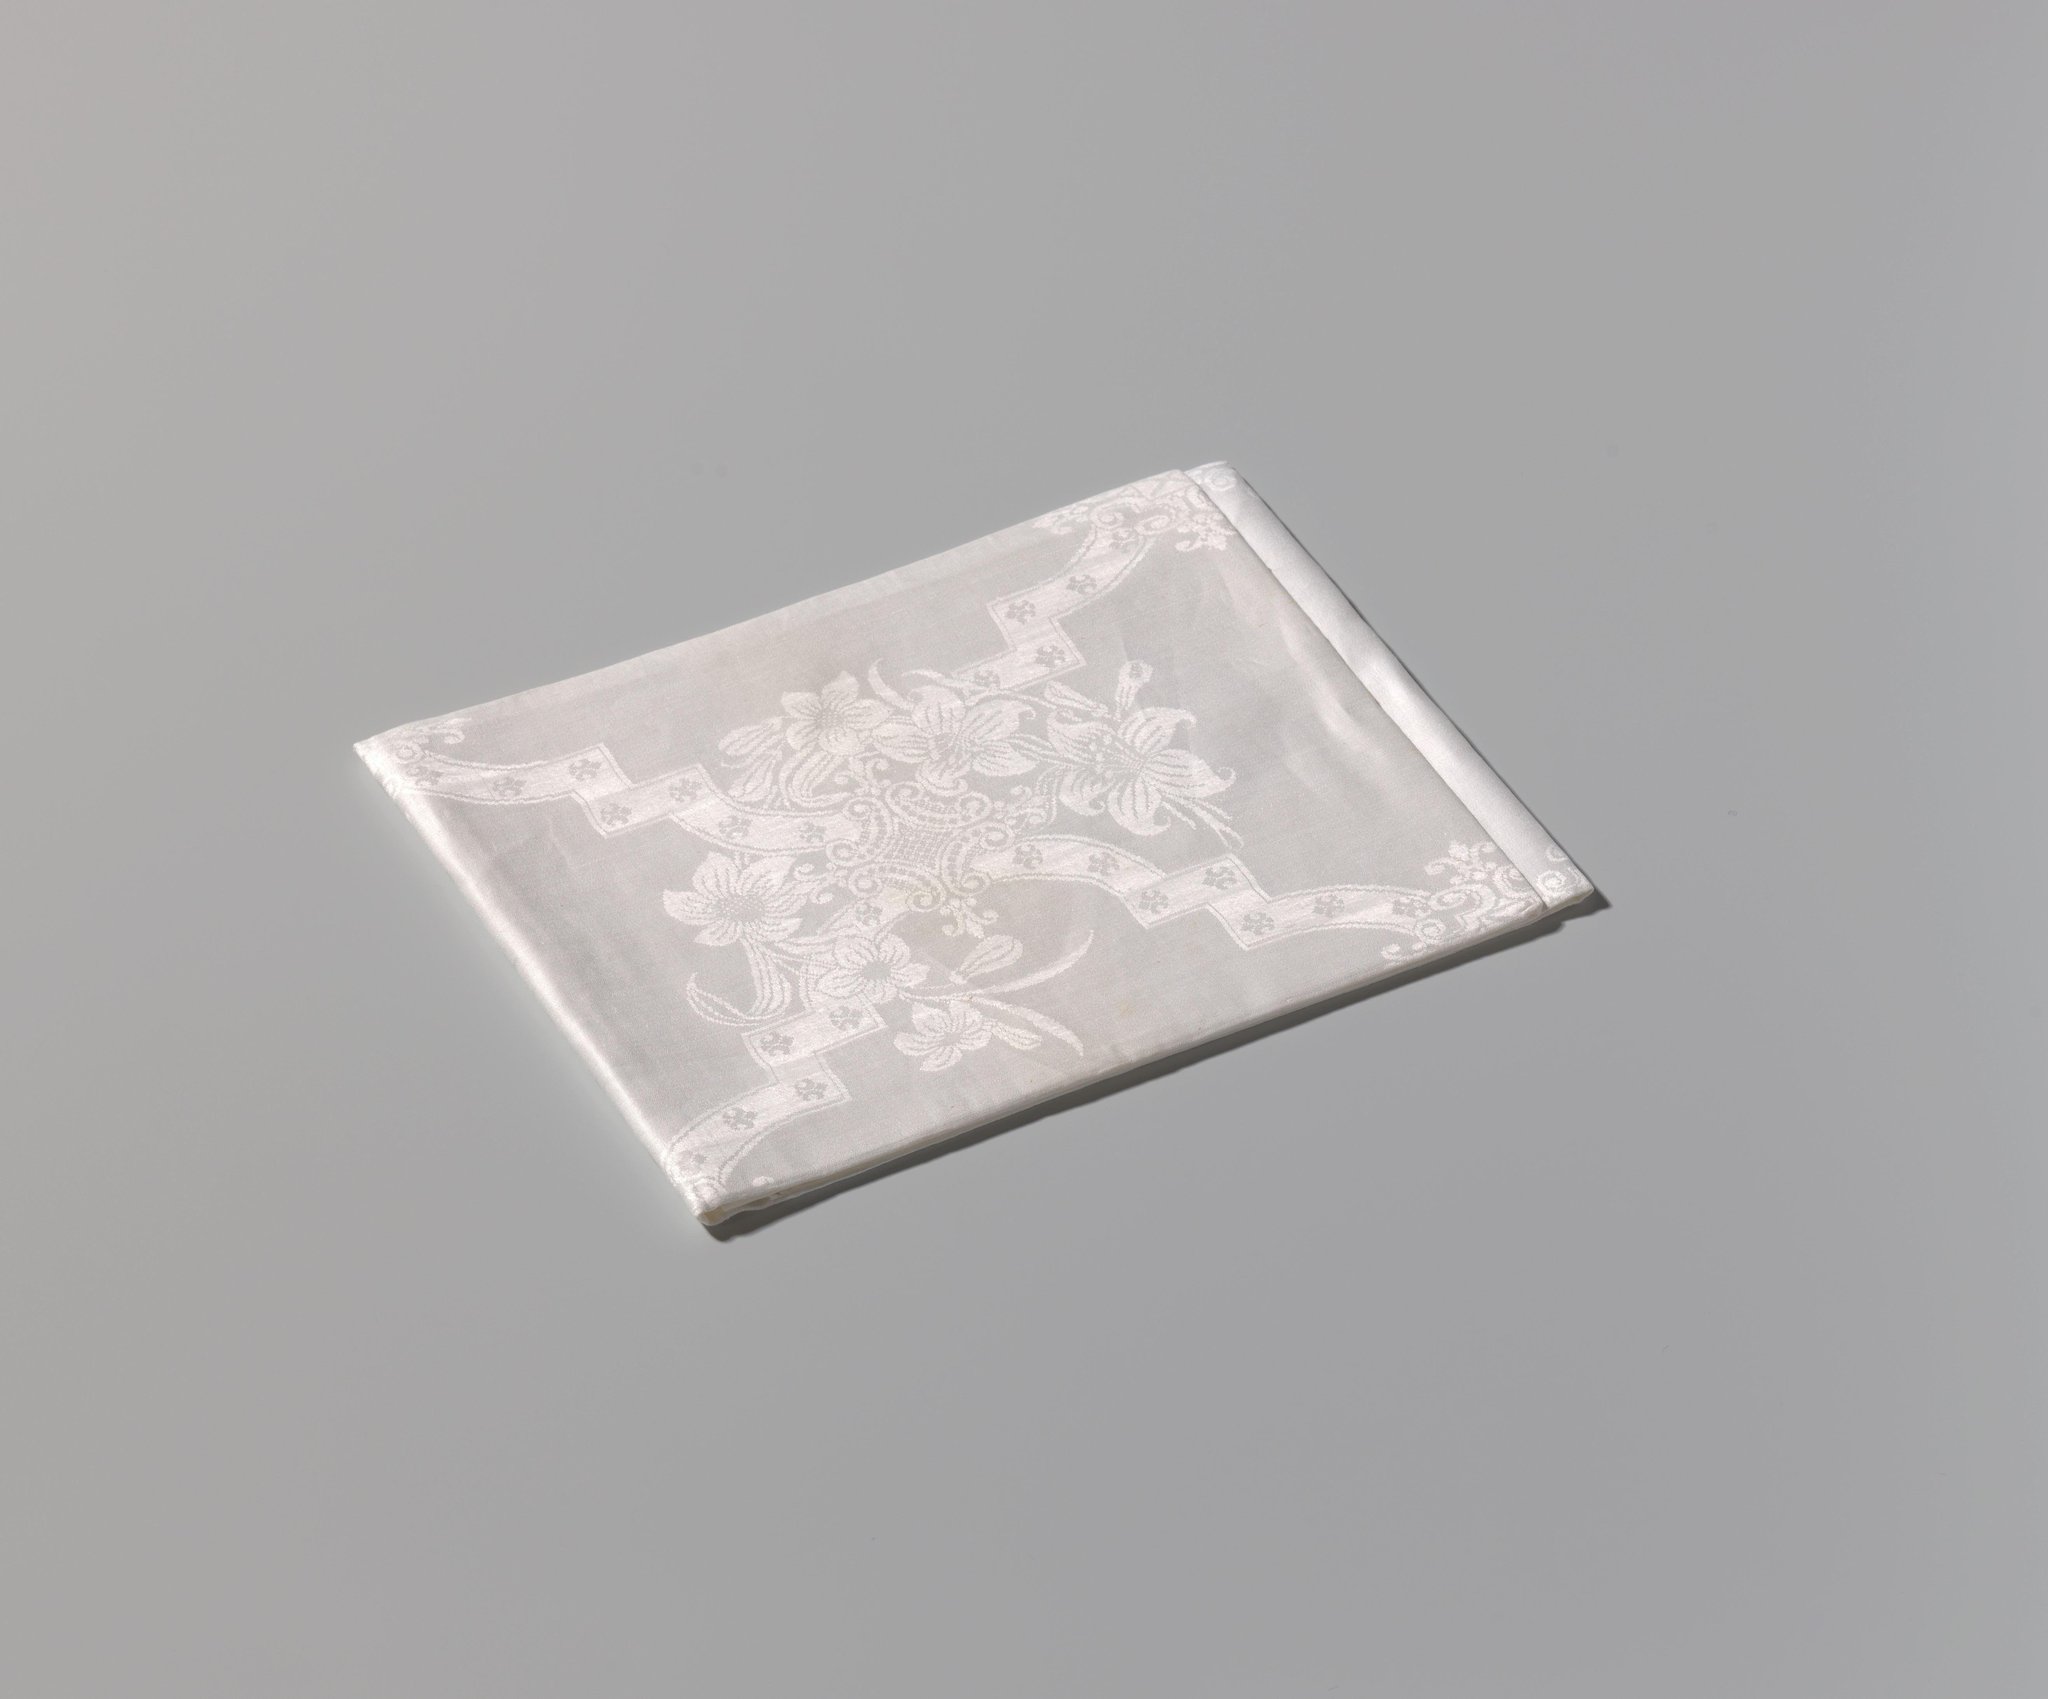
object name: napkin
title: Servet met fleurs de lys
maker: Anonymous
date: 1700-1710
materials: linen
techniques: damask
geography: dresden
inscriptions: label: ‘R.M. A'dam’, mark: ‘24’, mark: ‘BLS’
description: Servet van linnendamast met fleurs de lys. Slingerende banden vormen in de hoogte gerekte velden. De banden bestaan uit rechte en ronde delen, gevuld met kleine fleurs de lys; op de raakpunten een slingerende tak met leliën. De rand, alleen aan de buitenzijde omlijnd met fijne zigzagzomen en rolwerk met rastervulling, vertoont dicht aaneengesloten bloemboeketten, in de hoeken naar het midden gericht en voortkomend uit een draagstuk, waarop een fleur de lys. Rondom: blokkenrand.